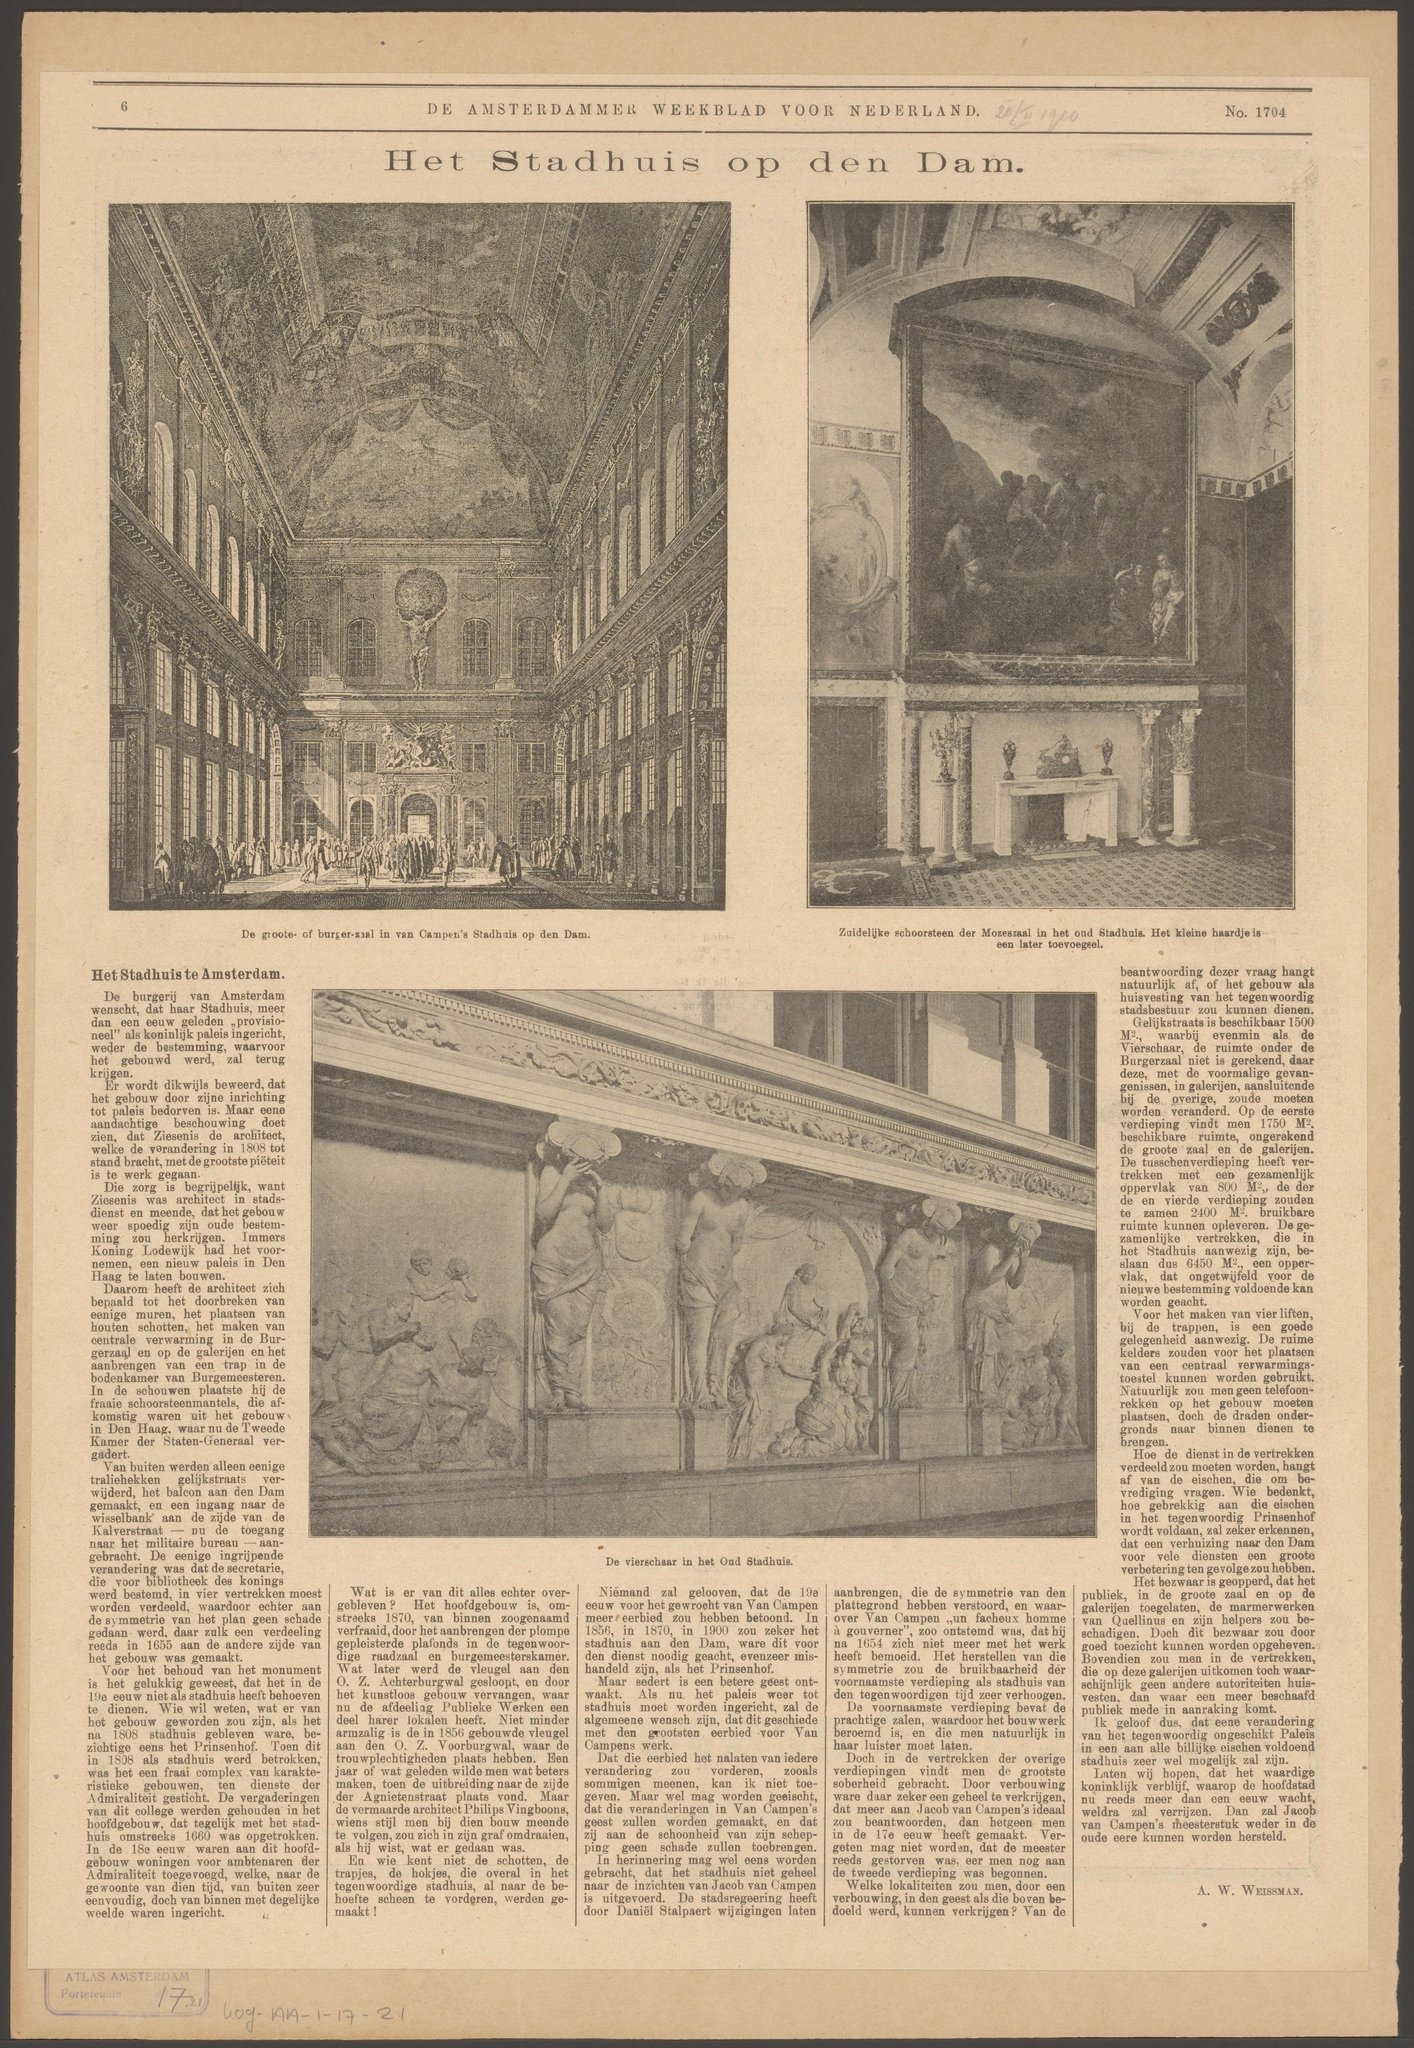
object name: photomechanical print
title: Gezichten op de Burgerzaal, de Mozeszaal en de Vierschaar in het Paleis op de Dam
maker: Anonymous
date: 1910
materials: paper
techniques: letterpress printing, line block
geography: amsterdam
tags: townhall, royal palace of amsterdam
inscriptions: collector's mark: ‘17.21’ Lugt 1641b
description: Onderwerpsrubriek binnen de Atlas Amsterdam: Nieuwe Stadhuis, van binnen: Groote zaal, Raadkamer, Schepenkamer, Troonzaal, Mozeszaal, Zitkamer.